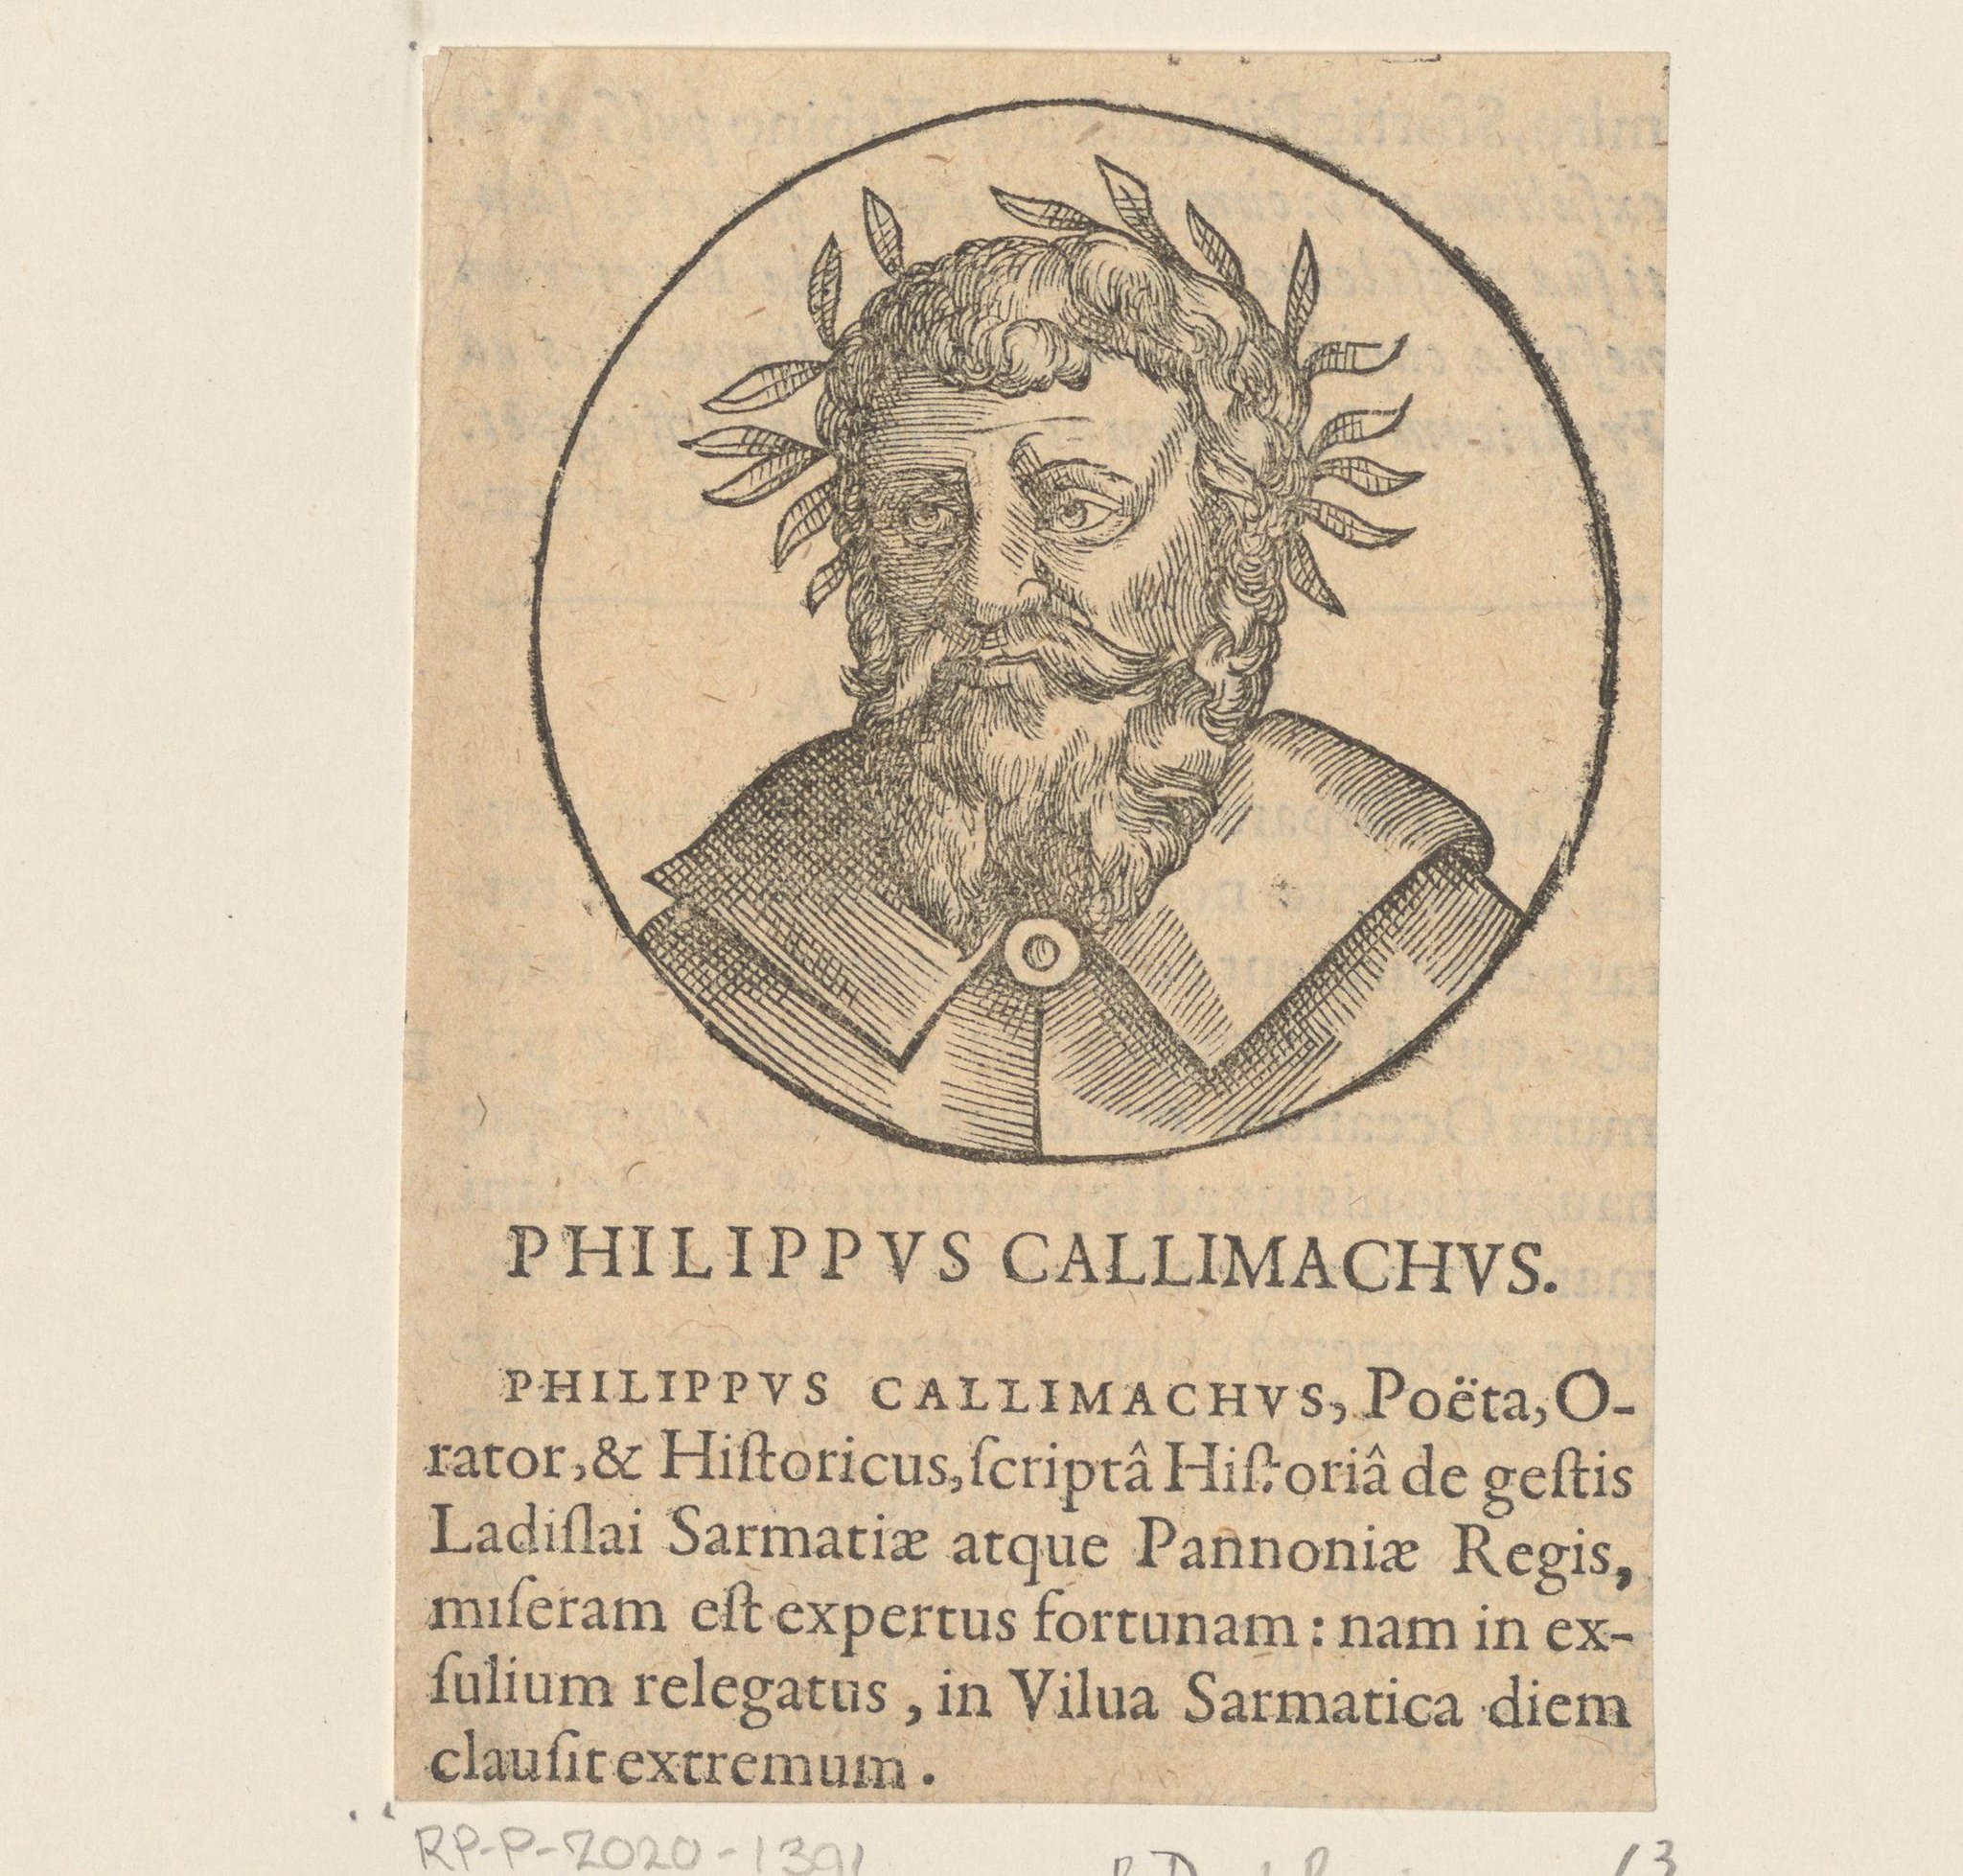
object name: print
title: Portret van Callimachus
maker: Anonymous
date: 1500-1599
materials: paper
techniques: letterpress printing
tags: historical persons